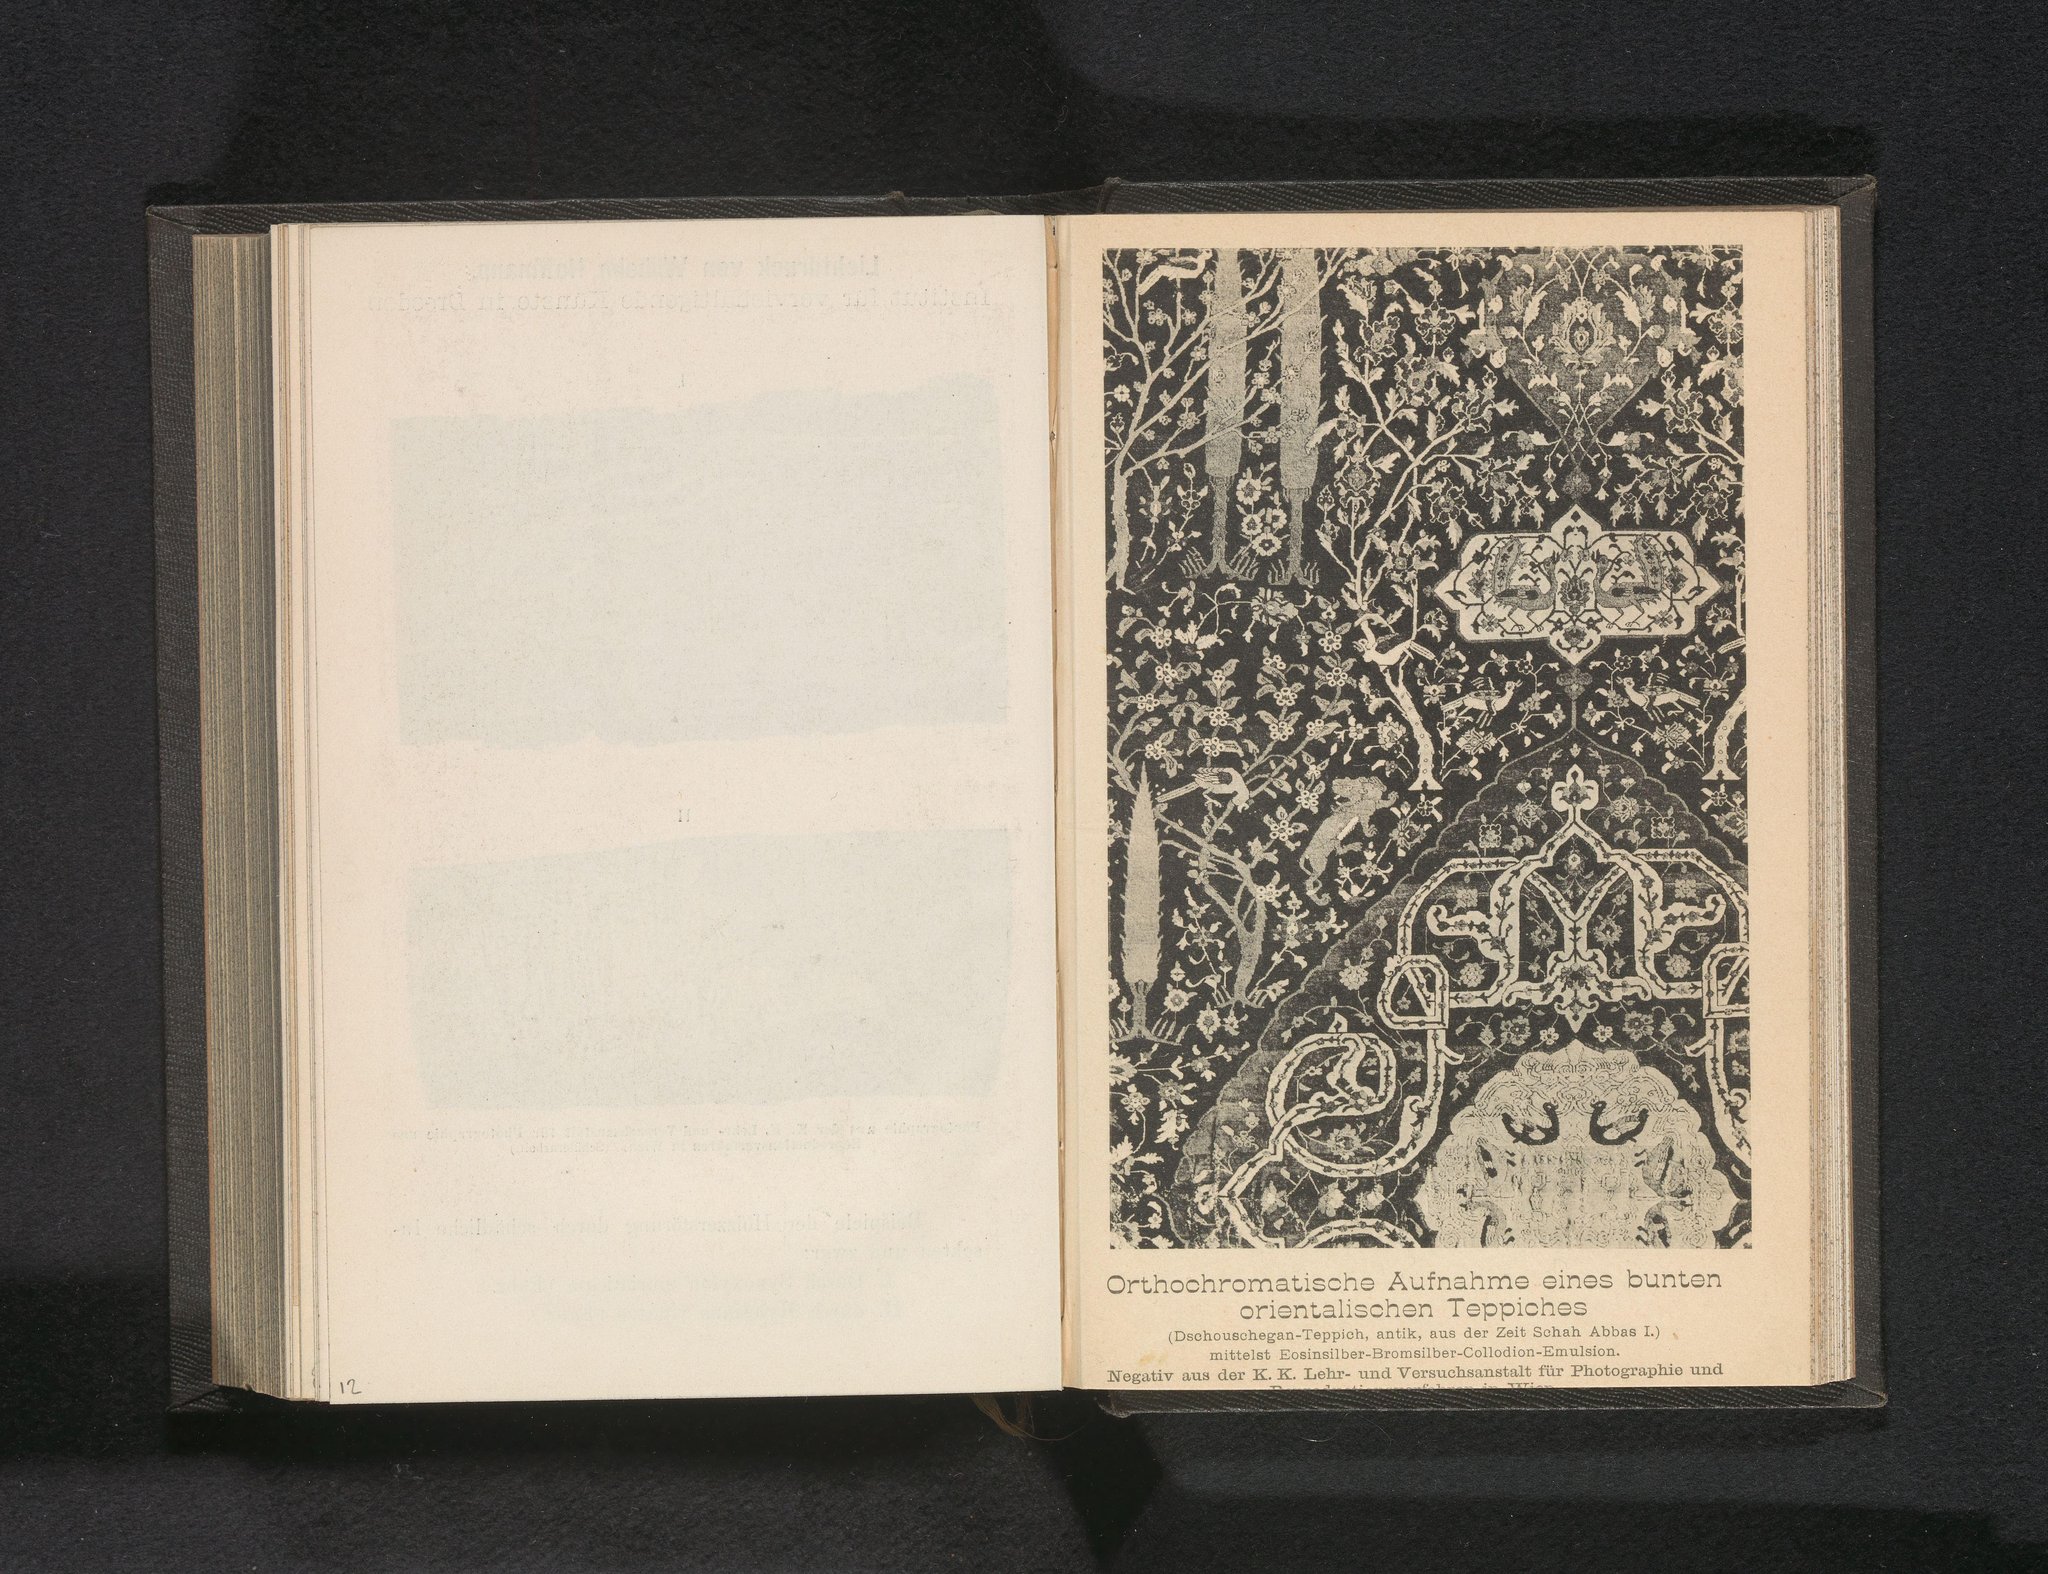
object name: photomechanical print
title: Oosters tapijt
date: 1887-1892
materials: paper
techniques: photograph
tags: carpet, rug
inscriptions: inscription: ‘Orthocrhomatische Aufnahme eines bunten orientalischen Teppisches (...)’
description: Prent op vijfentwintigste ongenummerde pagina na pagina 520.